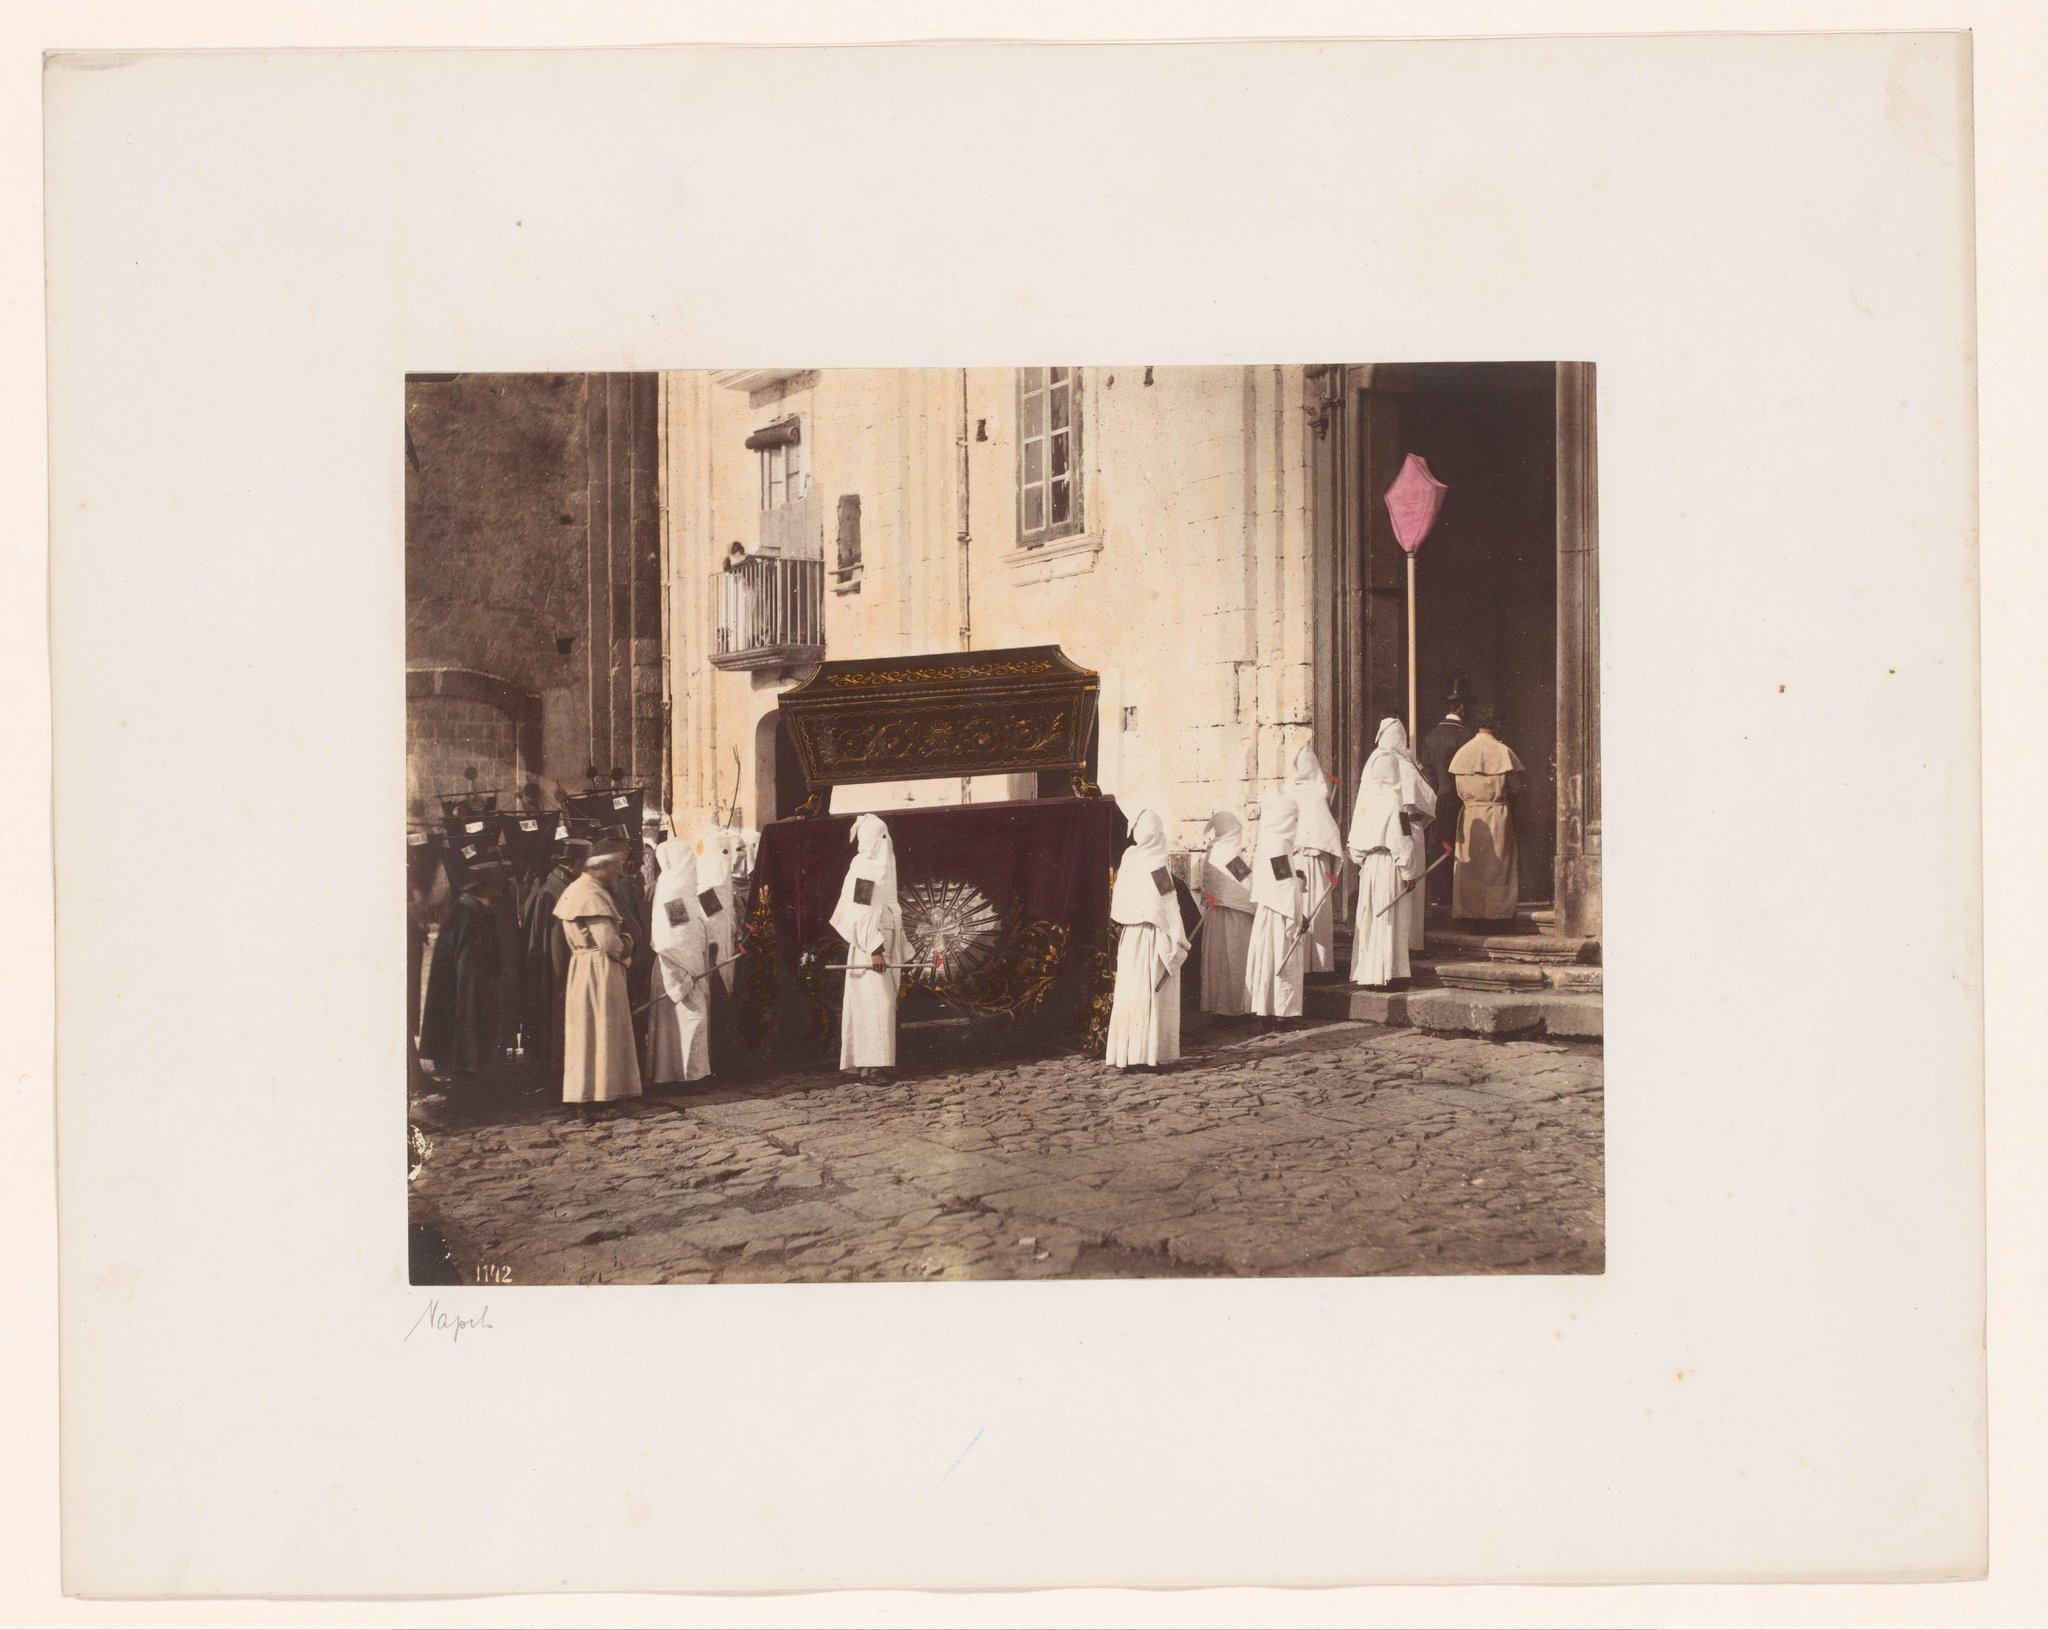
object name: photograph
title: Processie met lijkkist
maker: giorgio sommer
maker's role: fotograaf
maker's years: 1834-1914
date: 1868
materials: cardboard, paper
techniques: albumen print, hand coloring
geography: naples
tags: burial rites, naples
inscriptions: inscription: ‘Napels’, number: ‘1142’